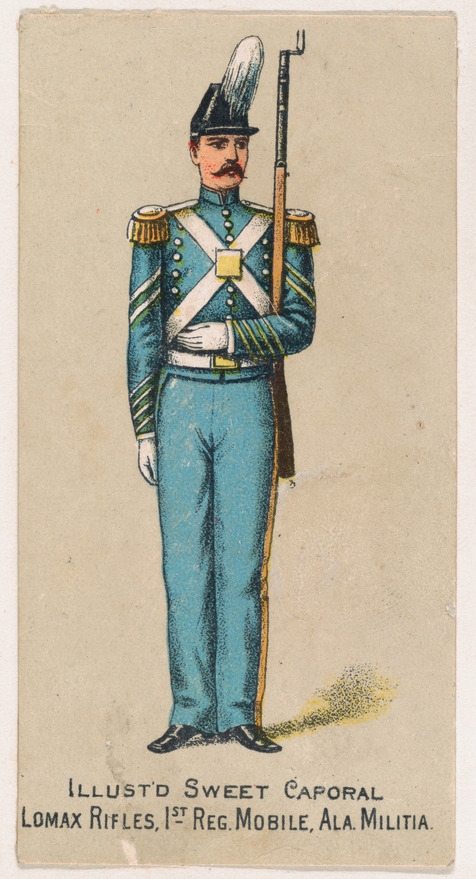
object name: print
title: Lomax Rifles, 1st Regiment, Mobile, Alabama Militia, from the Military Series (N224) issued by Kinney Tobacco Company to promote Sweet Caporal Cigarettes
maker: kinney brothers tobacco company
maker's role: publisher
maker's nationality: american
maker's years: 1869-2011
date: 1888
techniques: color lithograph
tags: military,men